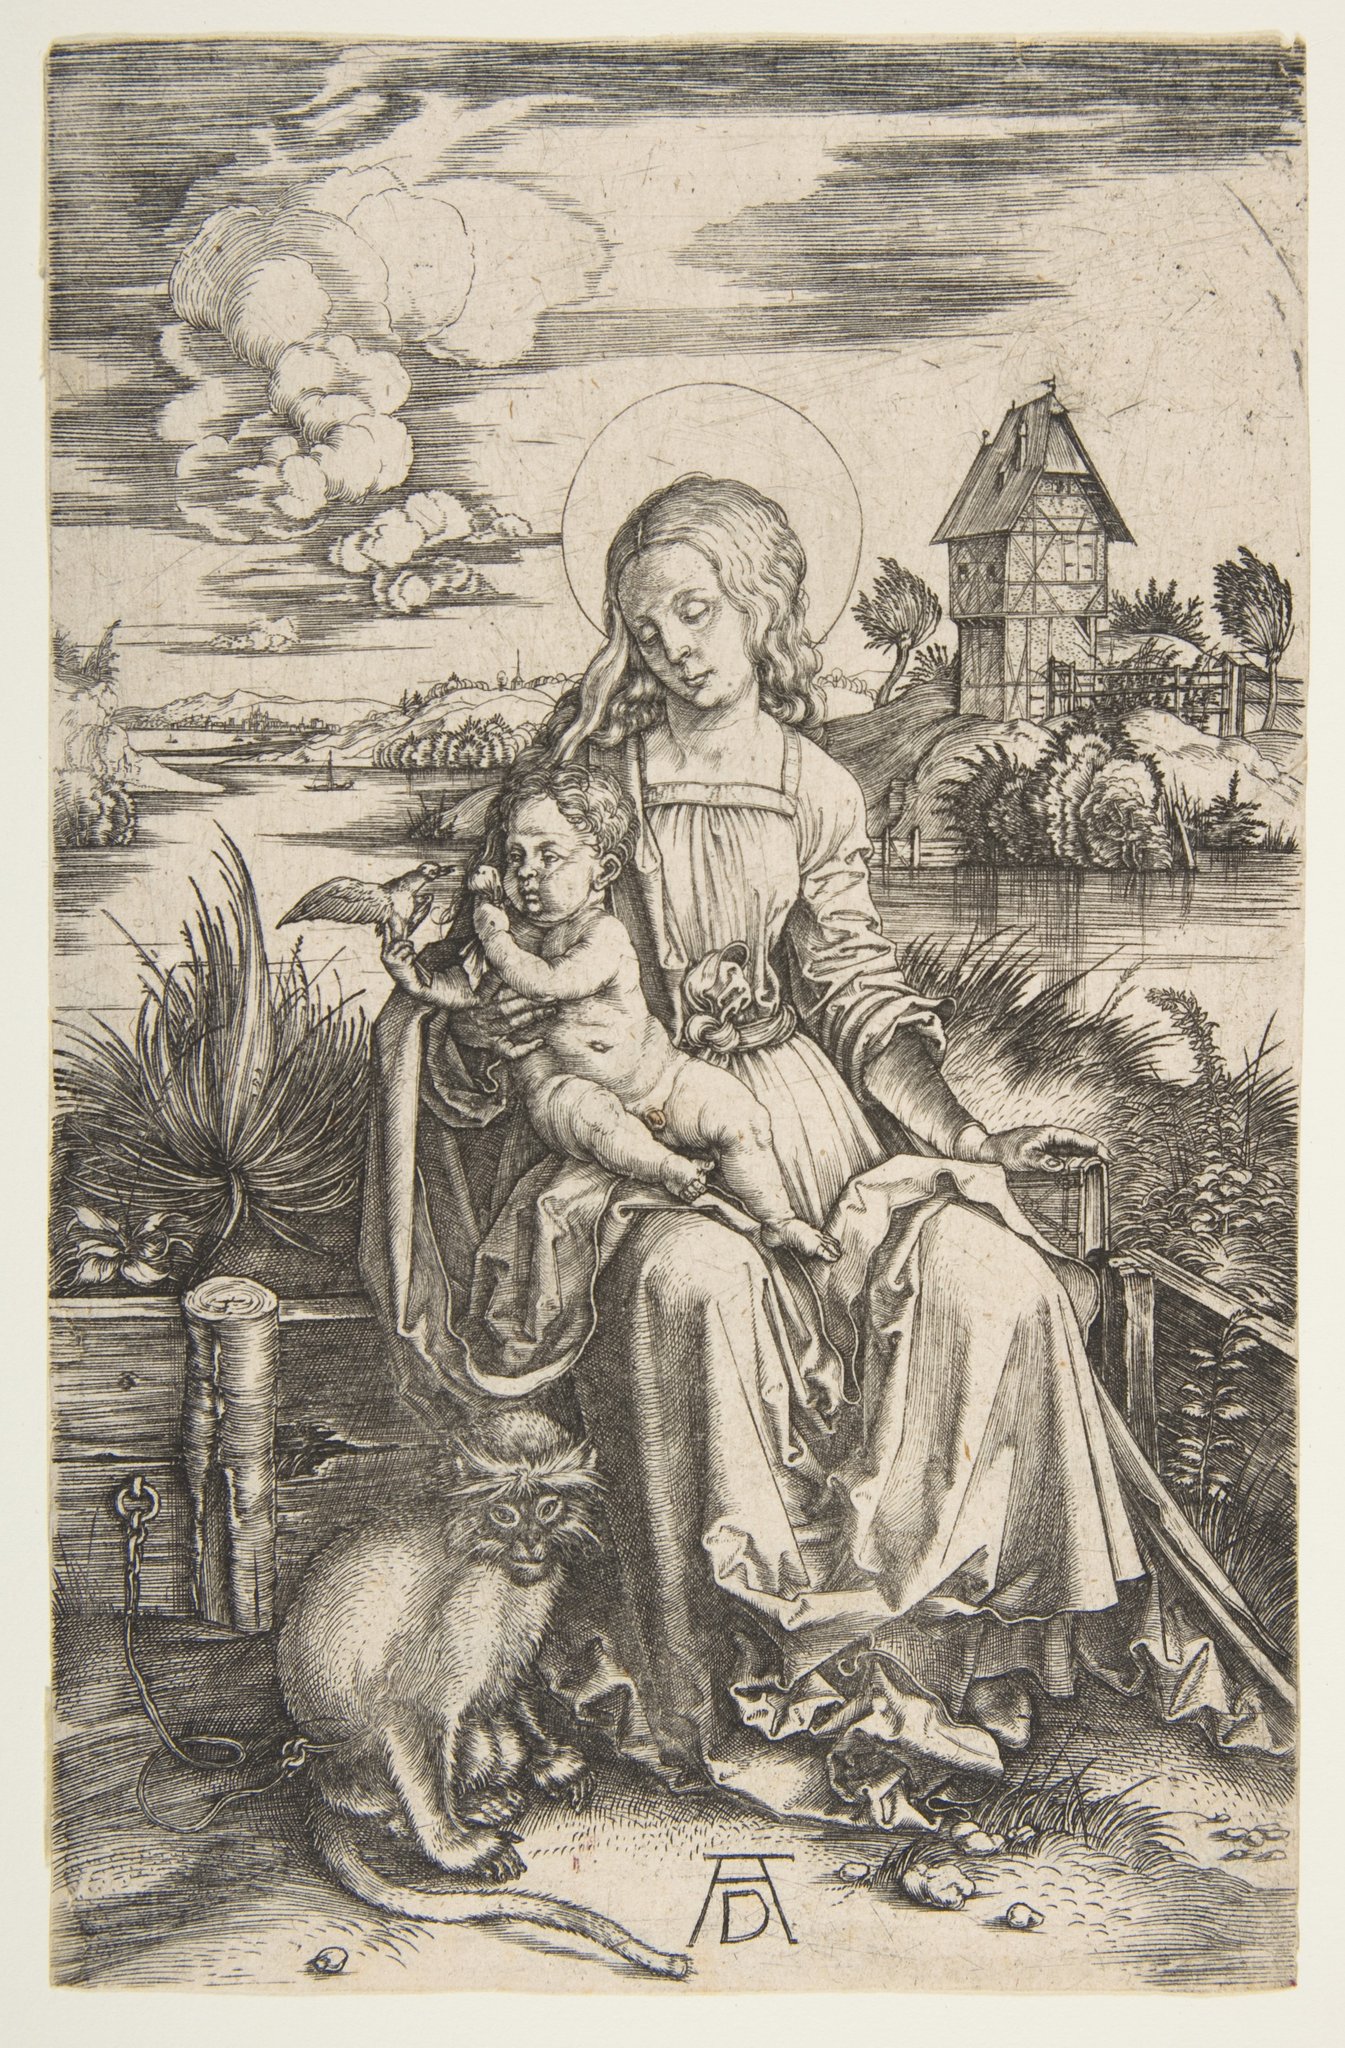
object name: print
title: Virgin and Child with the Monkey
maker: albrecht dürer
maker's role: artist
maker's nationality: german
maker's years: 1471-1528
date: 1498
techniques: engraving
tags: birds,monkeys,madonna and child